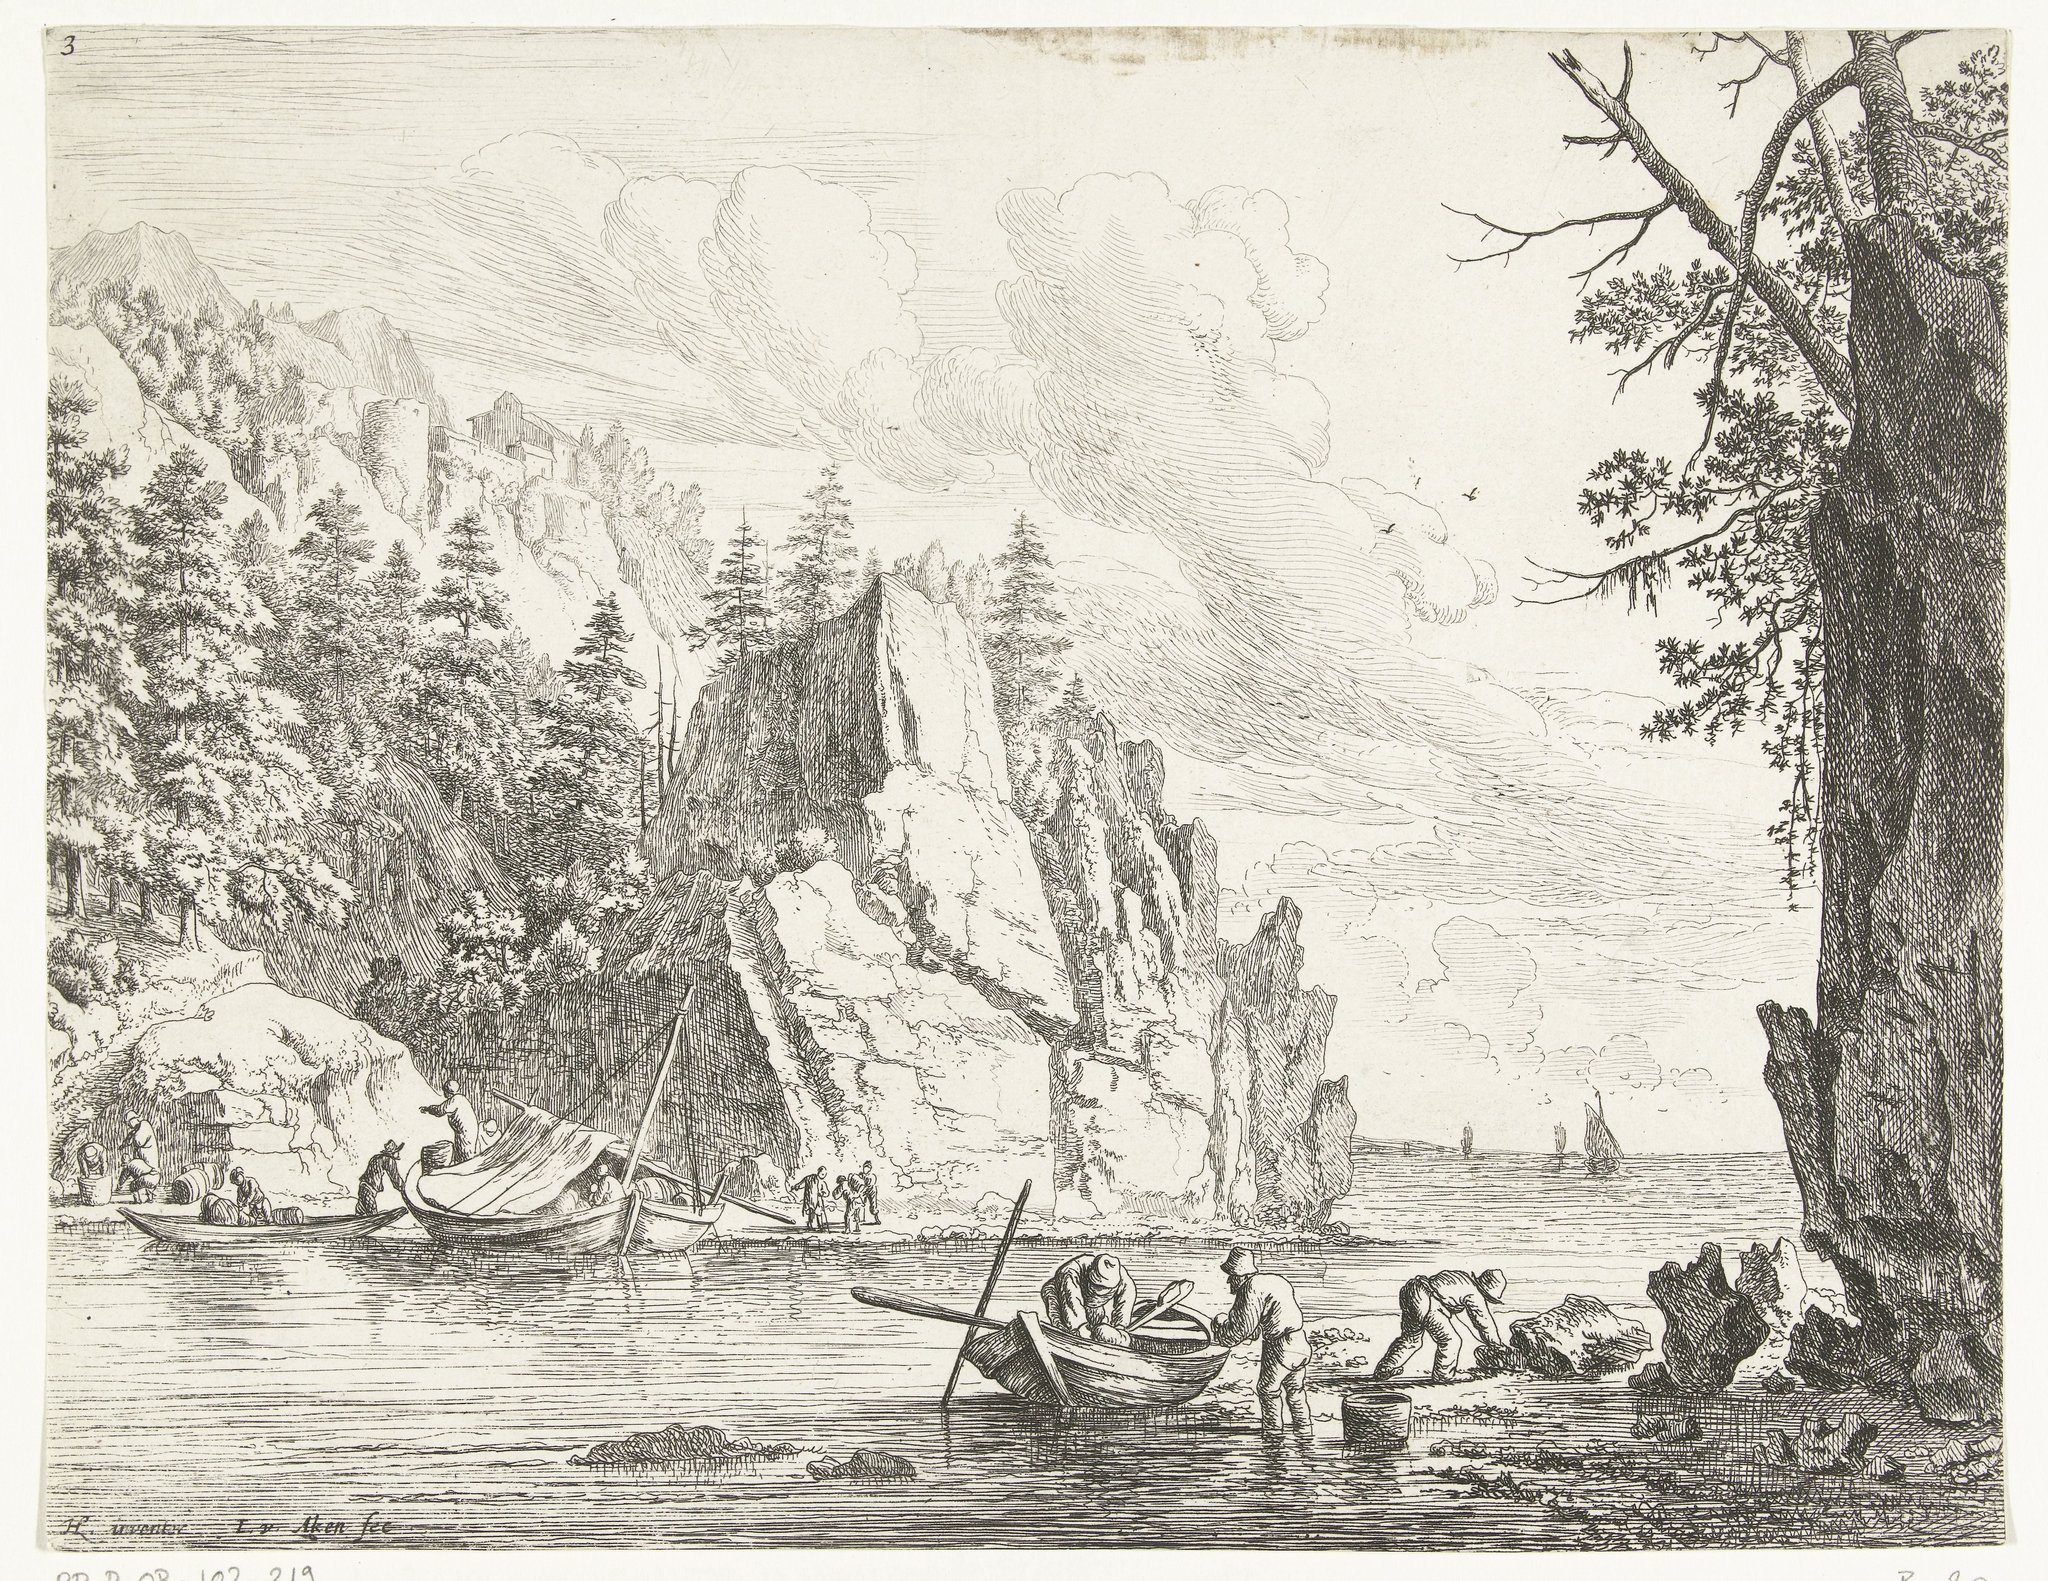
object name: print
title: Rijnlandschappen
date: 1624-1661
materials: paper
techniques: etching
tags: landscapes with waters, waterscapes, seascapes (in the temperate zone)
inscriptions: collector's mark: Lugt 789a, collector's mark: Lugt 2228